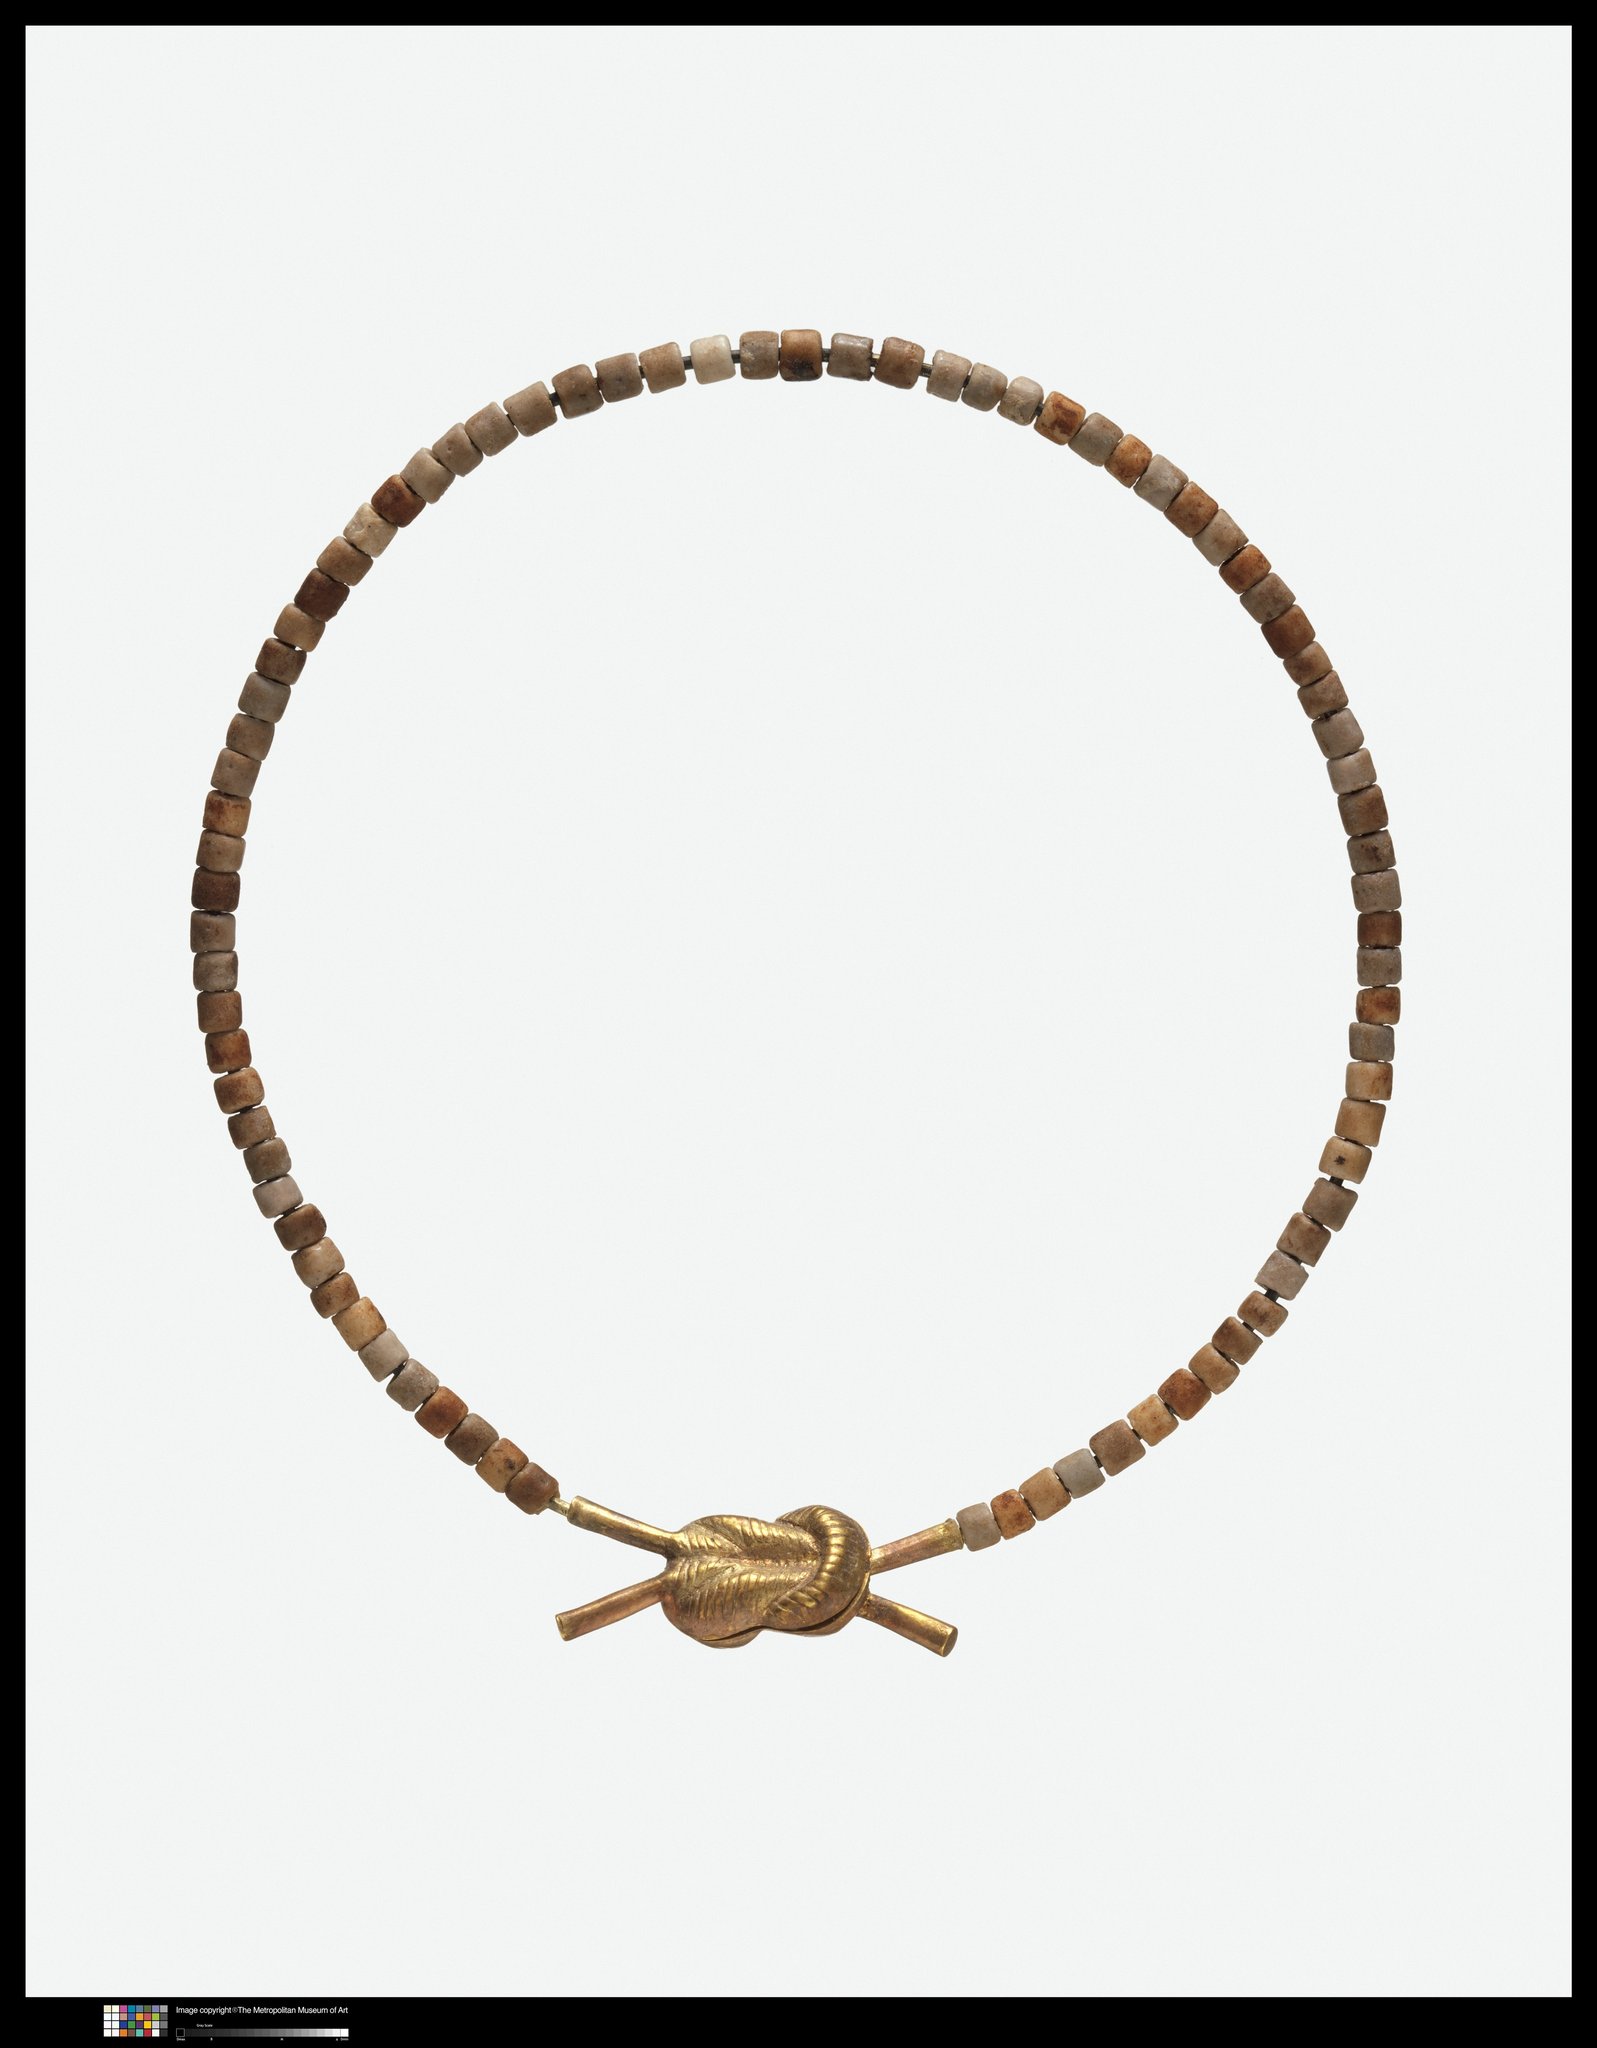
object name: clasp, senebtisi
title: Clasp from the tomb of Senebtisi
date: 1850-1775 BCE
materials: gold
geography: egypt